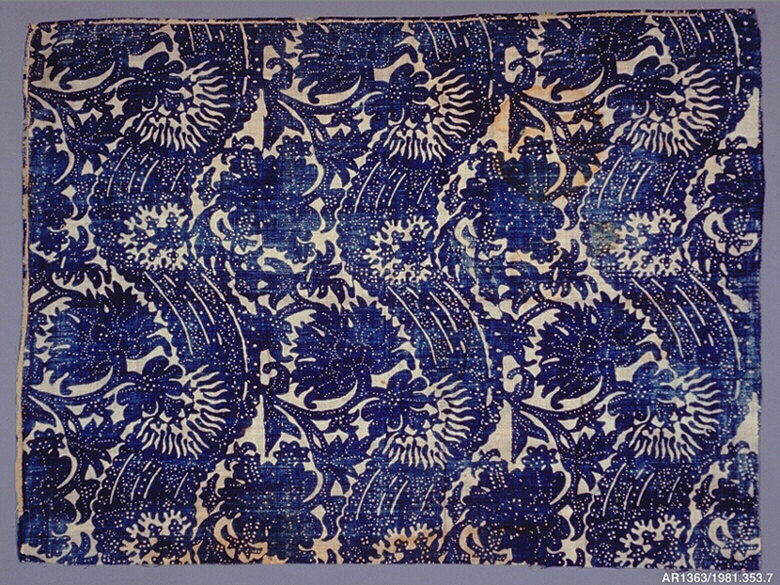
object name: piece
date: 1701-1800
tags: flowers